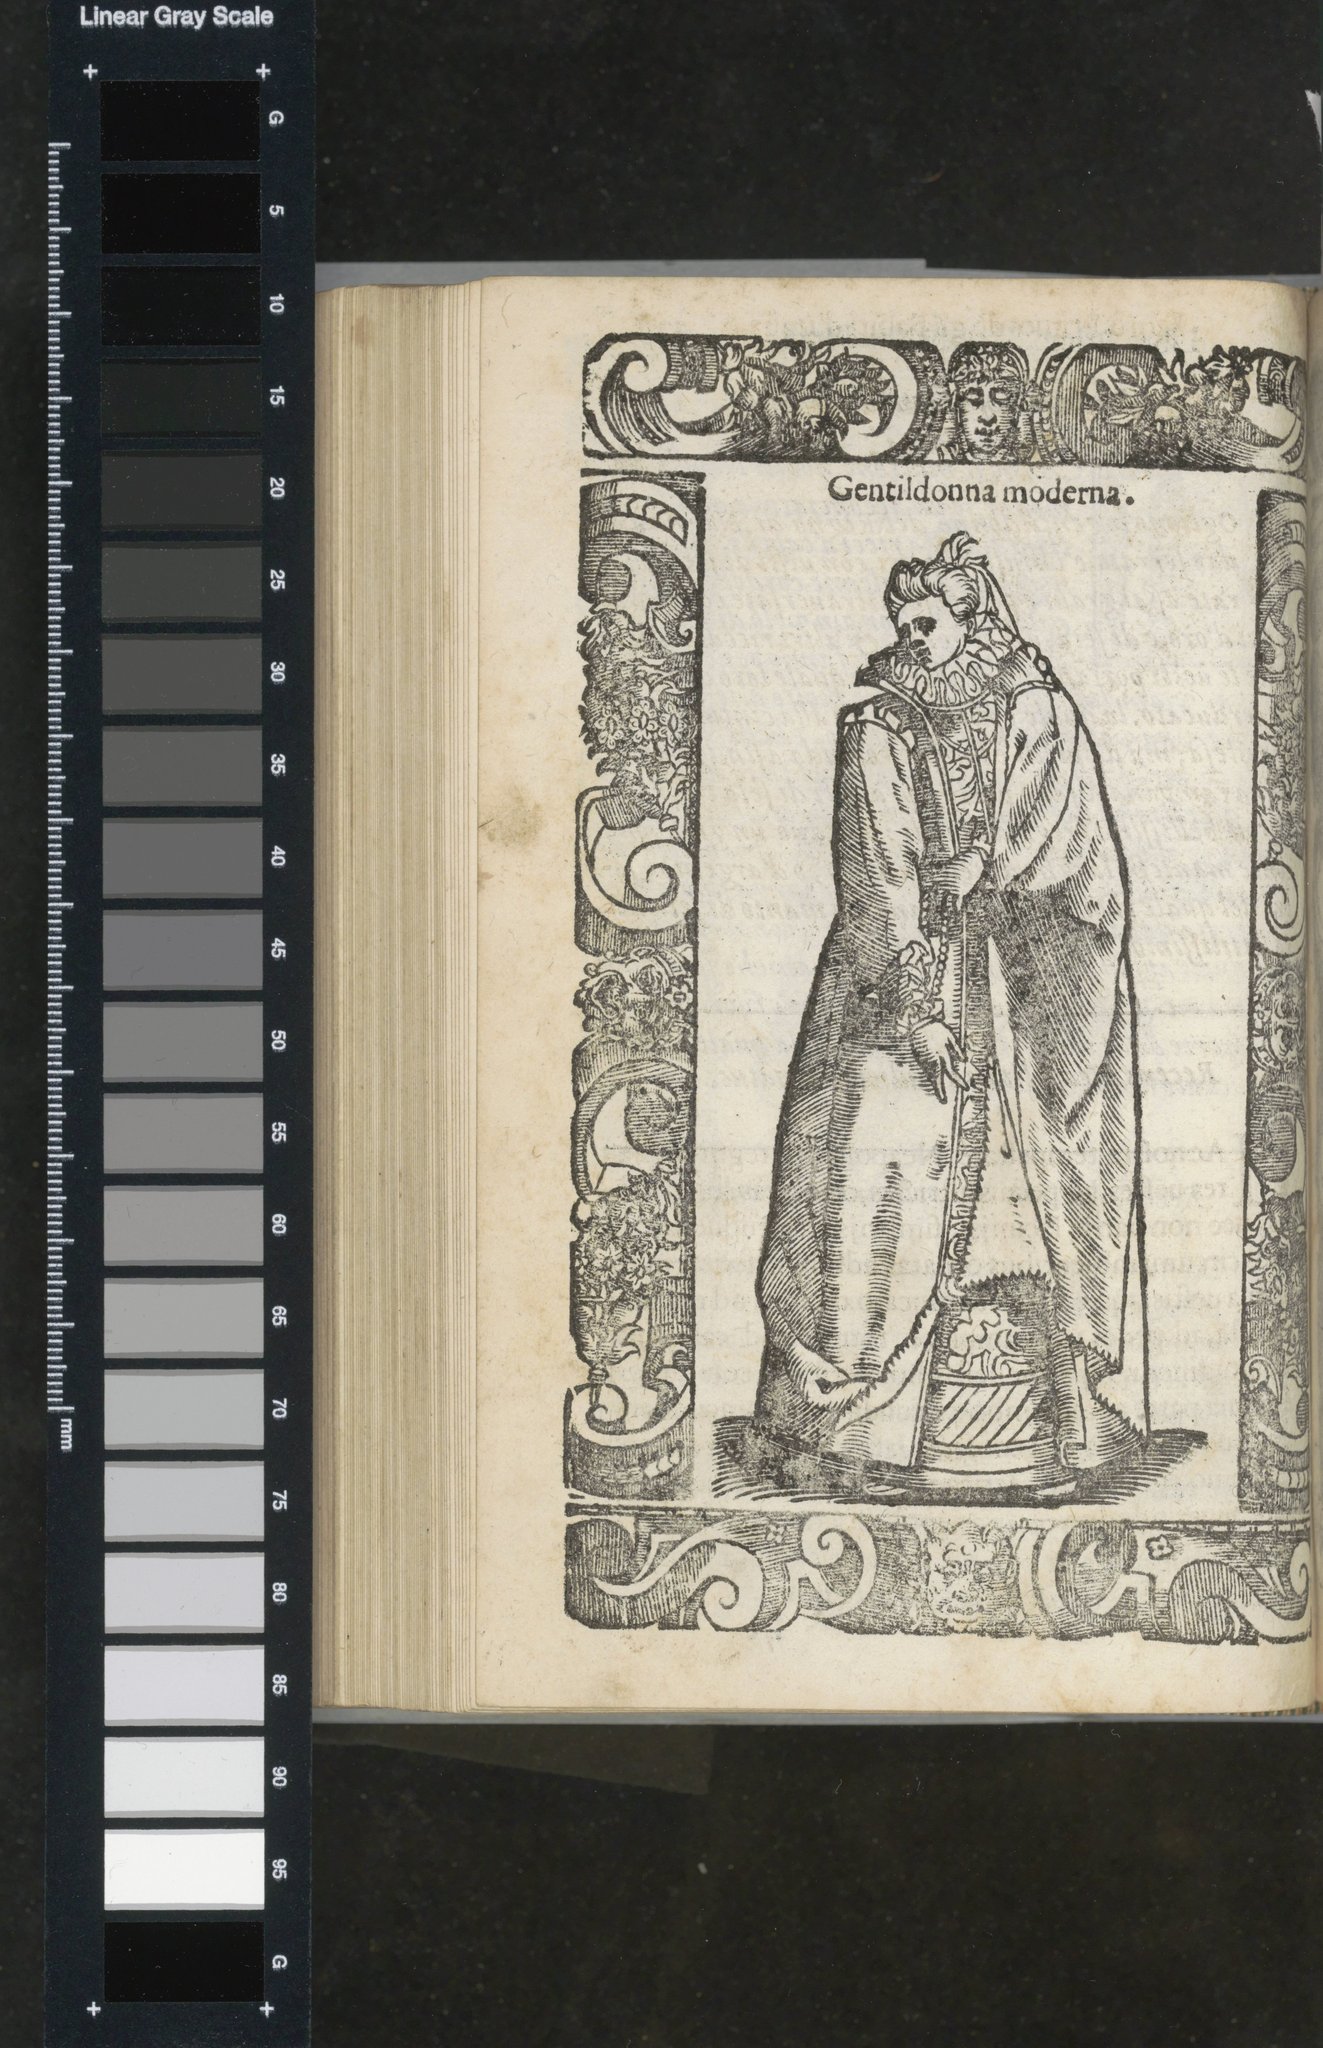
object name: costume print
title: Habiti antichi, et moderni di tutto il mondo...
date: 1598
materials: paper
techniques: woodcut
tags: veil (+ women's clothes), fashion plates, neck-gear ~ clothing (with name) (+ women's clothes), dress, gown (+ women's clothes)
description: Omdat het koninkrijk Napels uit zeven provincies bestaat, zijn er verschillende kledingstijlen. De adellijke dames dragen hoog gesloten gewaden en rijk geborduurde overkleden van gekleurde zijde. Onder de rokken wordt de fardegalijn gedragen (zodat de rok de vorm van een bel aanneemt) In plaats van een lijfje draagt men een wambuis met mouwen van goud- of zilverkleurige zijde dat aan de rok is bevestigd met knopen. Het overkleed wordt 'robba' genoemd. Hoge plooikraag om de hals, sluier in het haar.